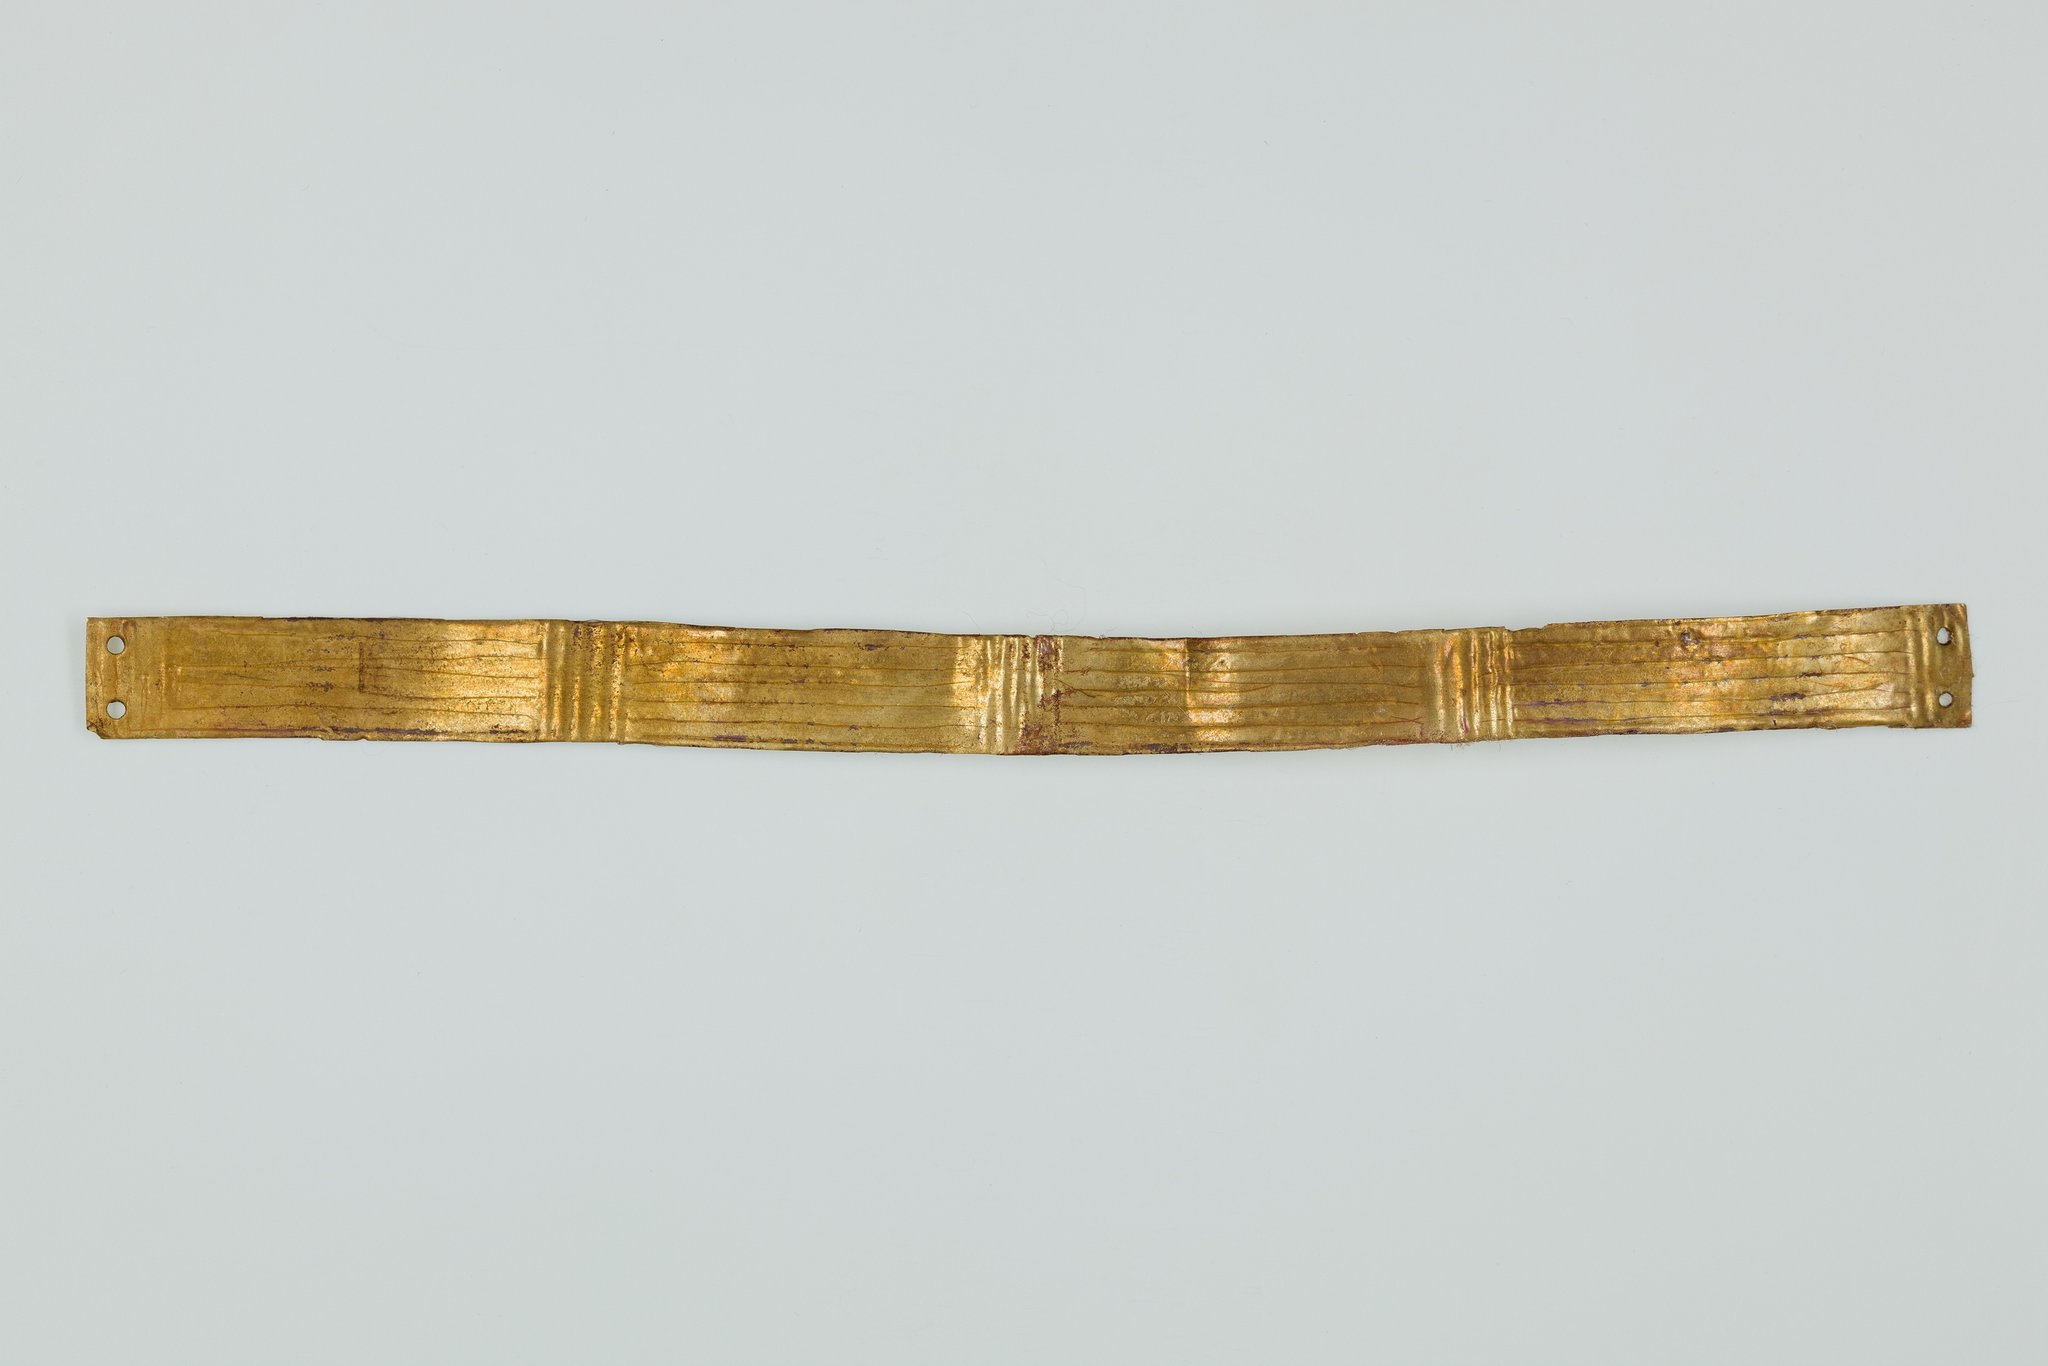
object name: amulet, sheet gold, bracelet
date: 664-380 BCE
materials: gold